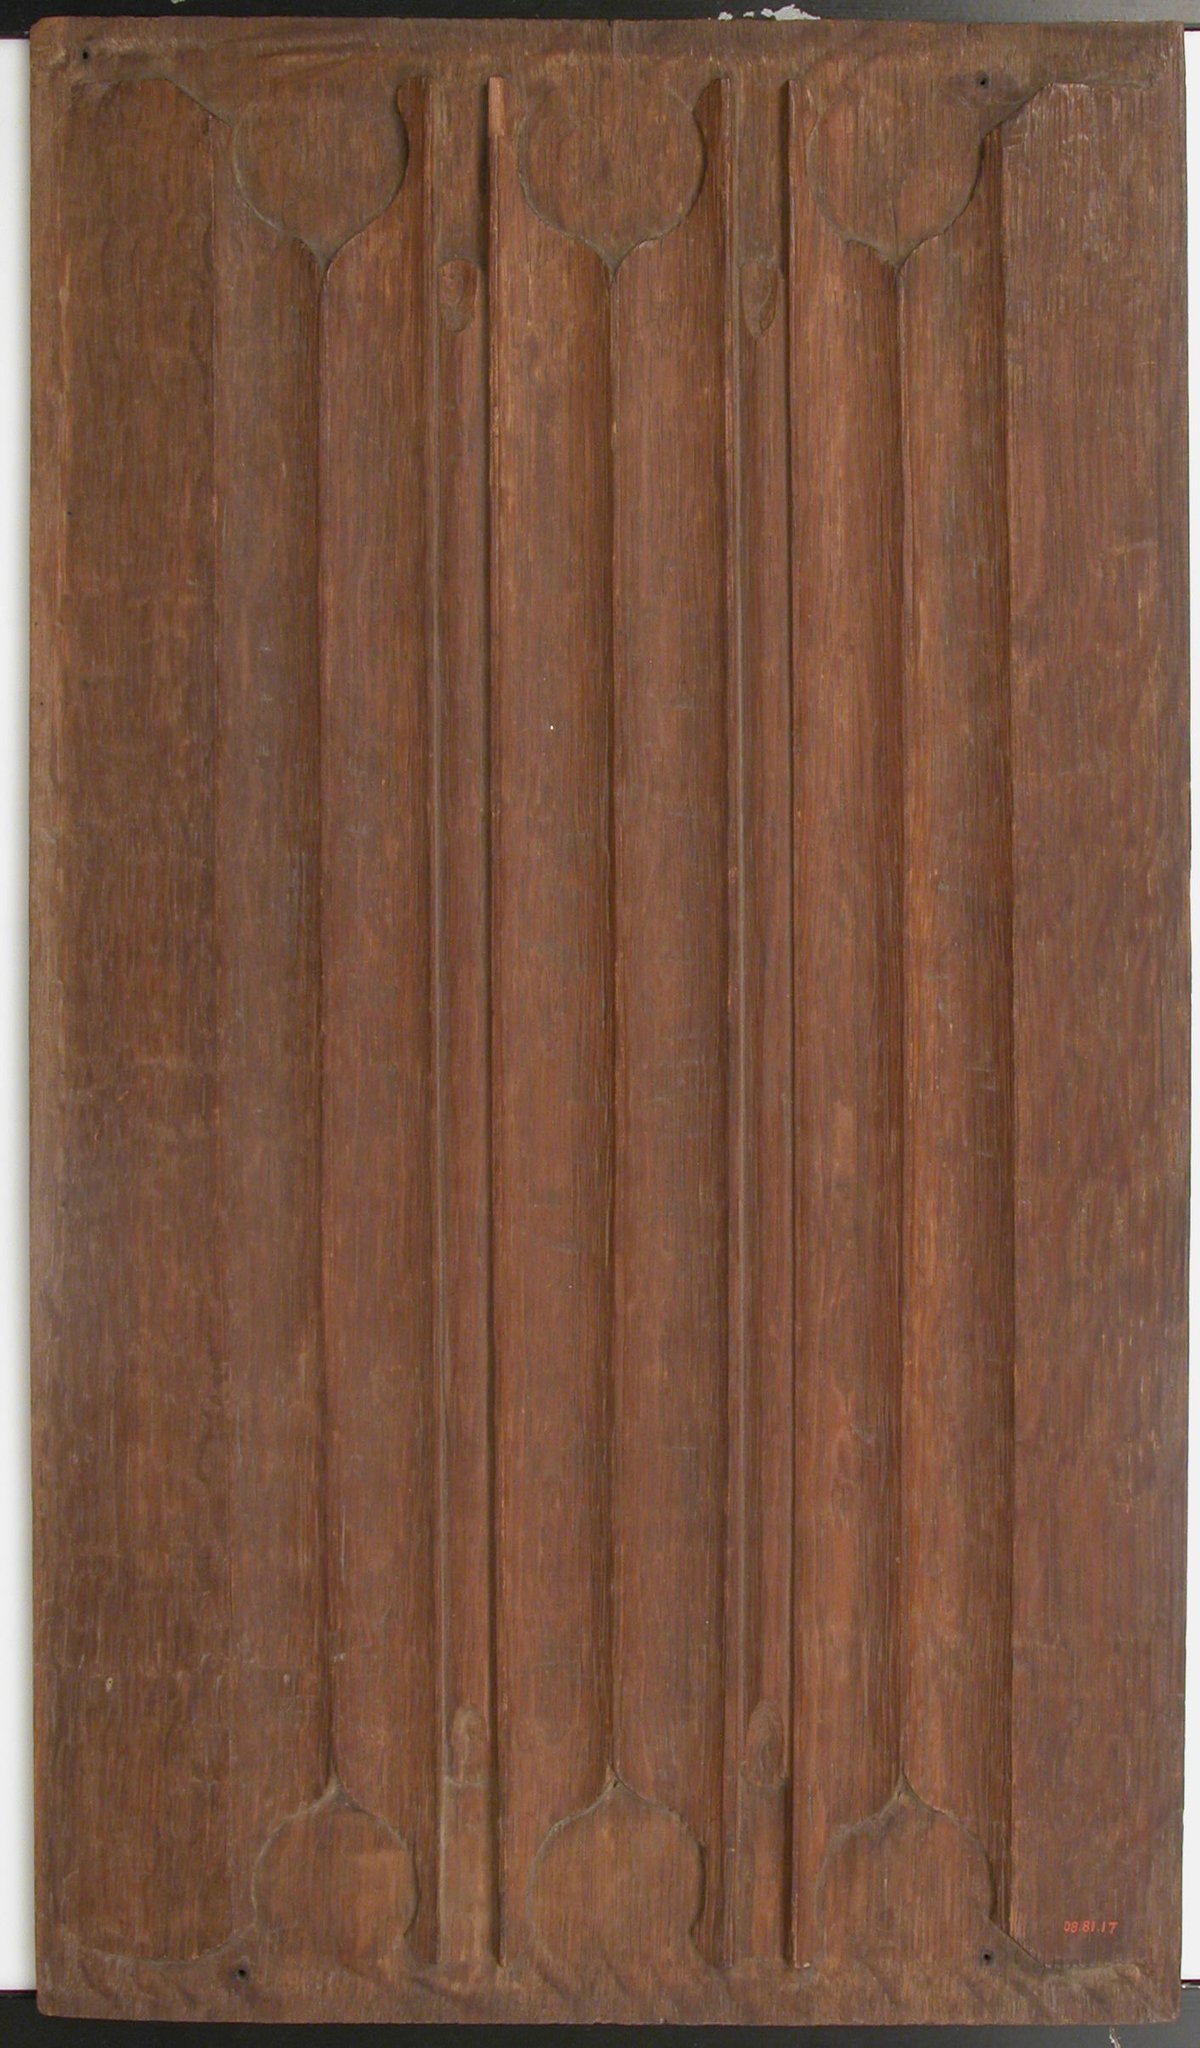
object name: panel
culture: european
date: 1501-1600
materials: wood